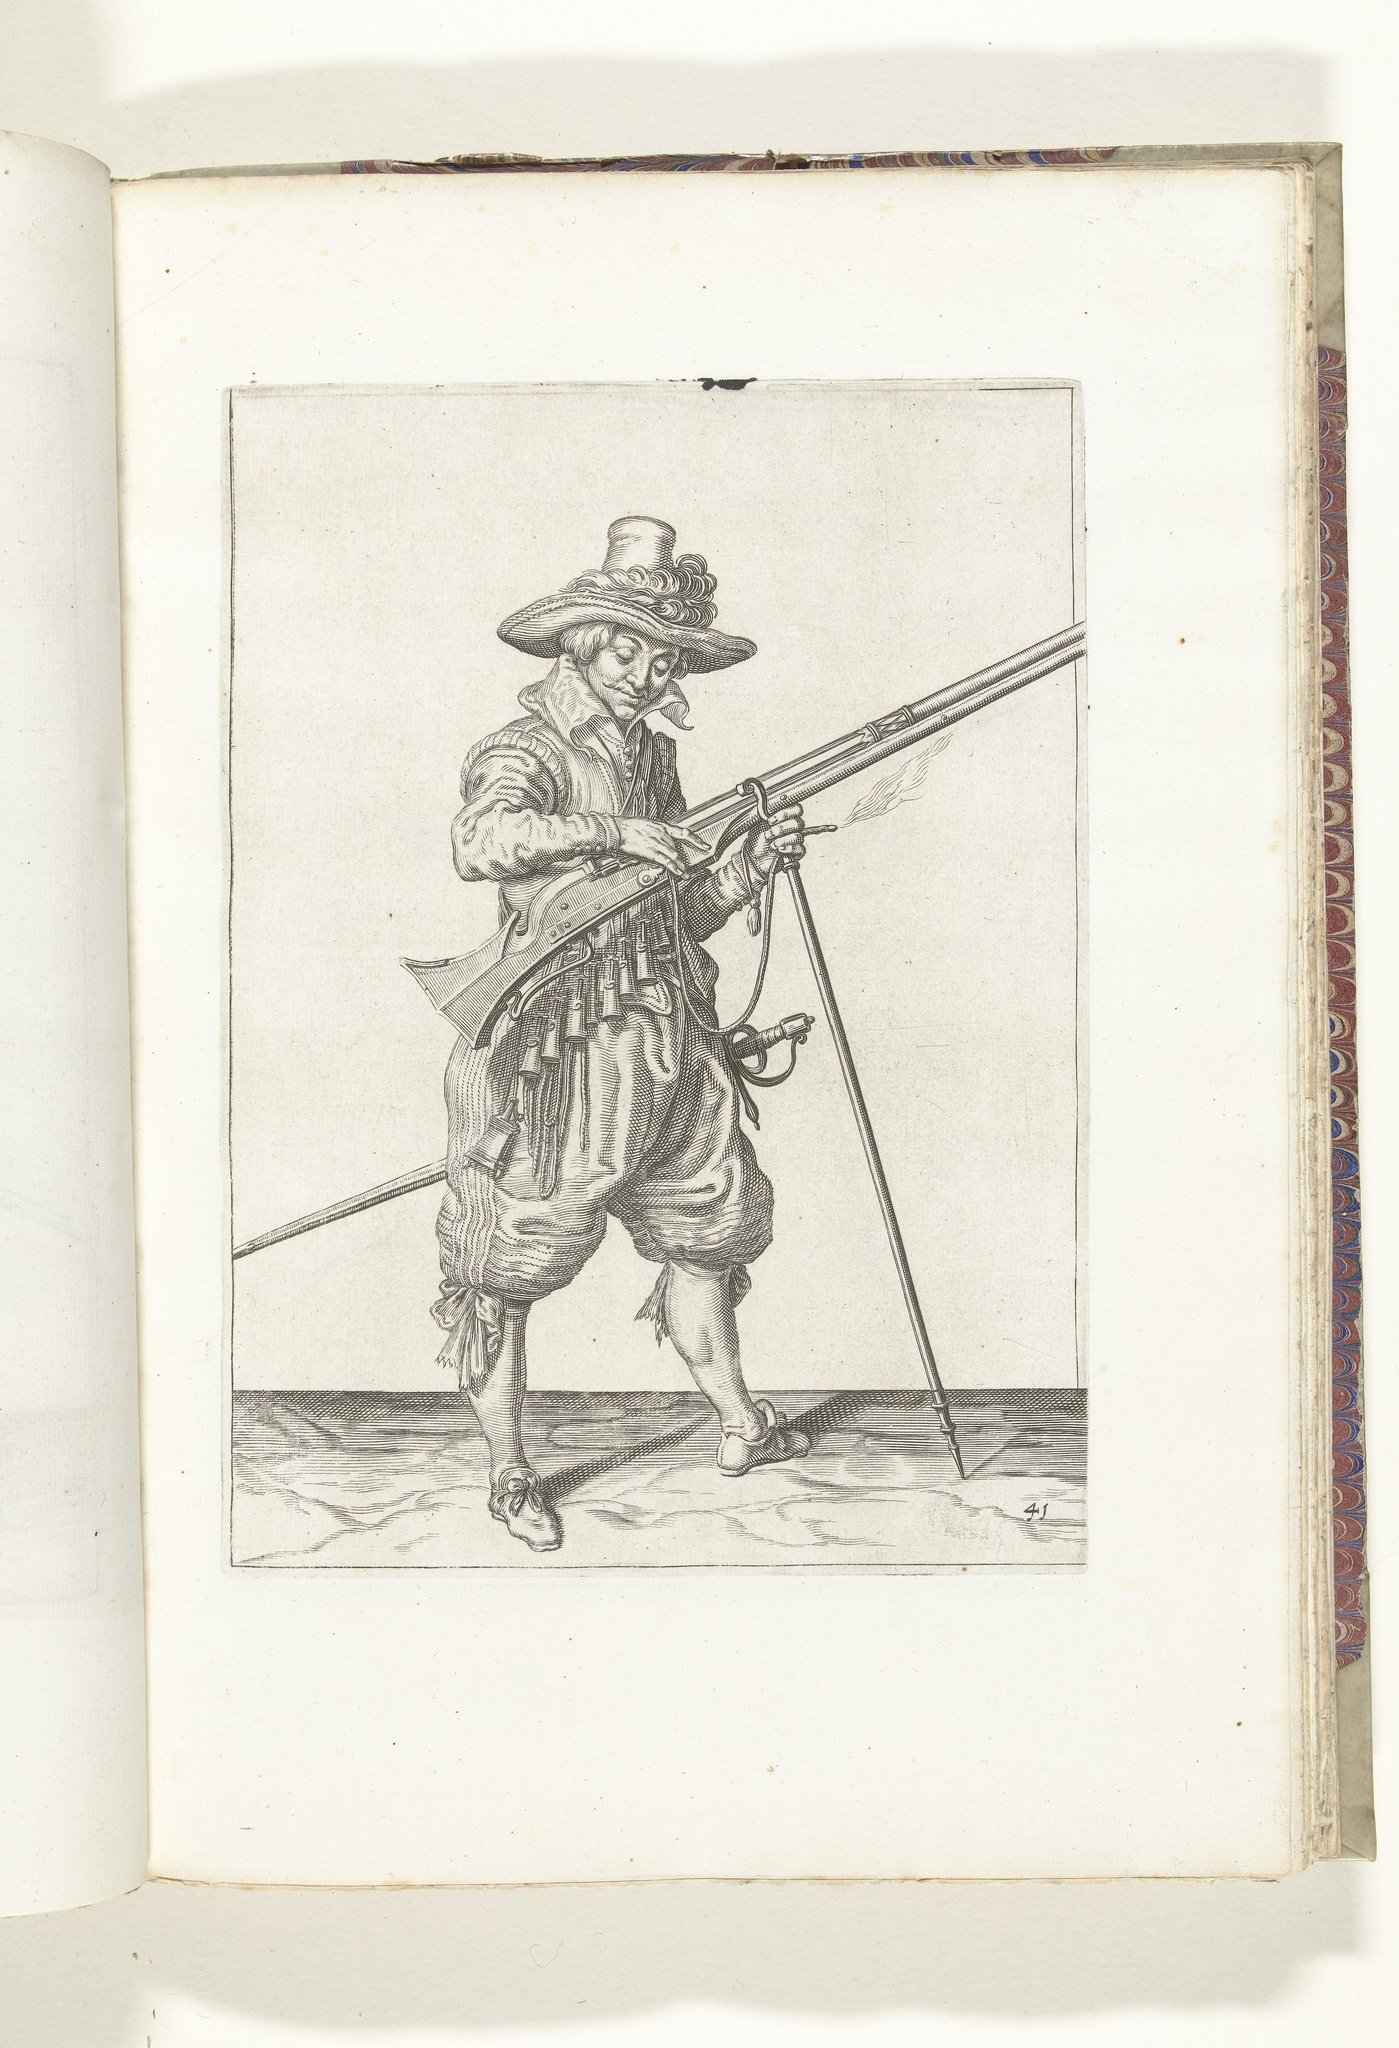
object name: print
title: Soldaat op wacht die zijn lont op de haan van zijn musket drukt (nr. 41), ca. 1600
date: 1597-1607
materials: paper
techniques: engraving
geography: amsterdam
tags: the hague, maurice (prince of orange), handling of weapons ~ military training, weapons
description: Een soldaat op wacht, ten voeten uit, naar rechts, die een musket (een bepaald type vuurwapen) met zijn linkerhand vasthoudt bij de vork van het furket (musketvork) waar de loop op steunt (nr. 41), ca. 1600. Met zijn rechterhand drukt hij een brandende lont op de haan (onderdeel van het ontstekingsmechanisme) van zijn musket. Plaat 41 in de instructies voor het hanteren van het musket: Corte onderrechtinghe op de figuerlicke afbeeldinghe, soo veel aengaet het recht ghebruyck van Musquet. Onderdeel van de illustraties in: J. de Gheyn, Wapenhandelinghe van Roers Musquetten ende spiessen, Amsterdam, 1608. Krijgswezen rond 1600.